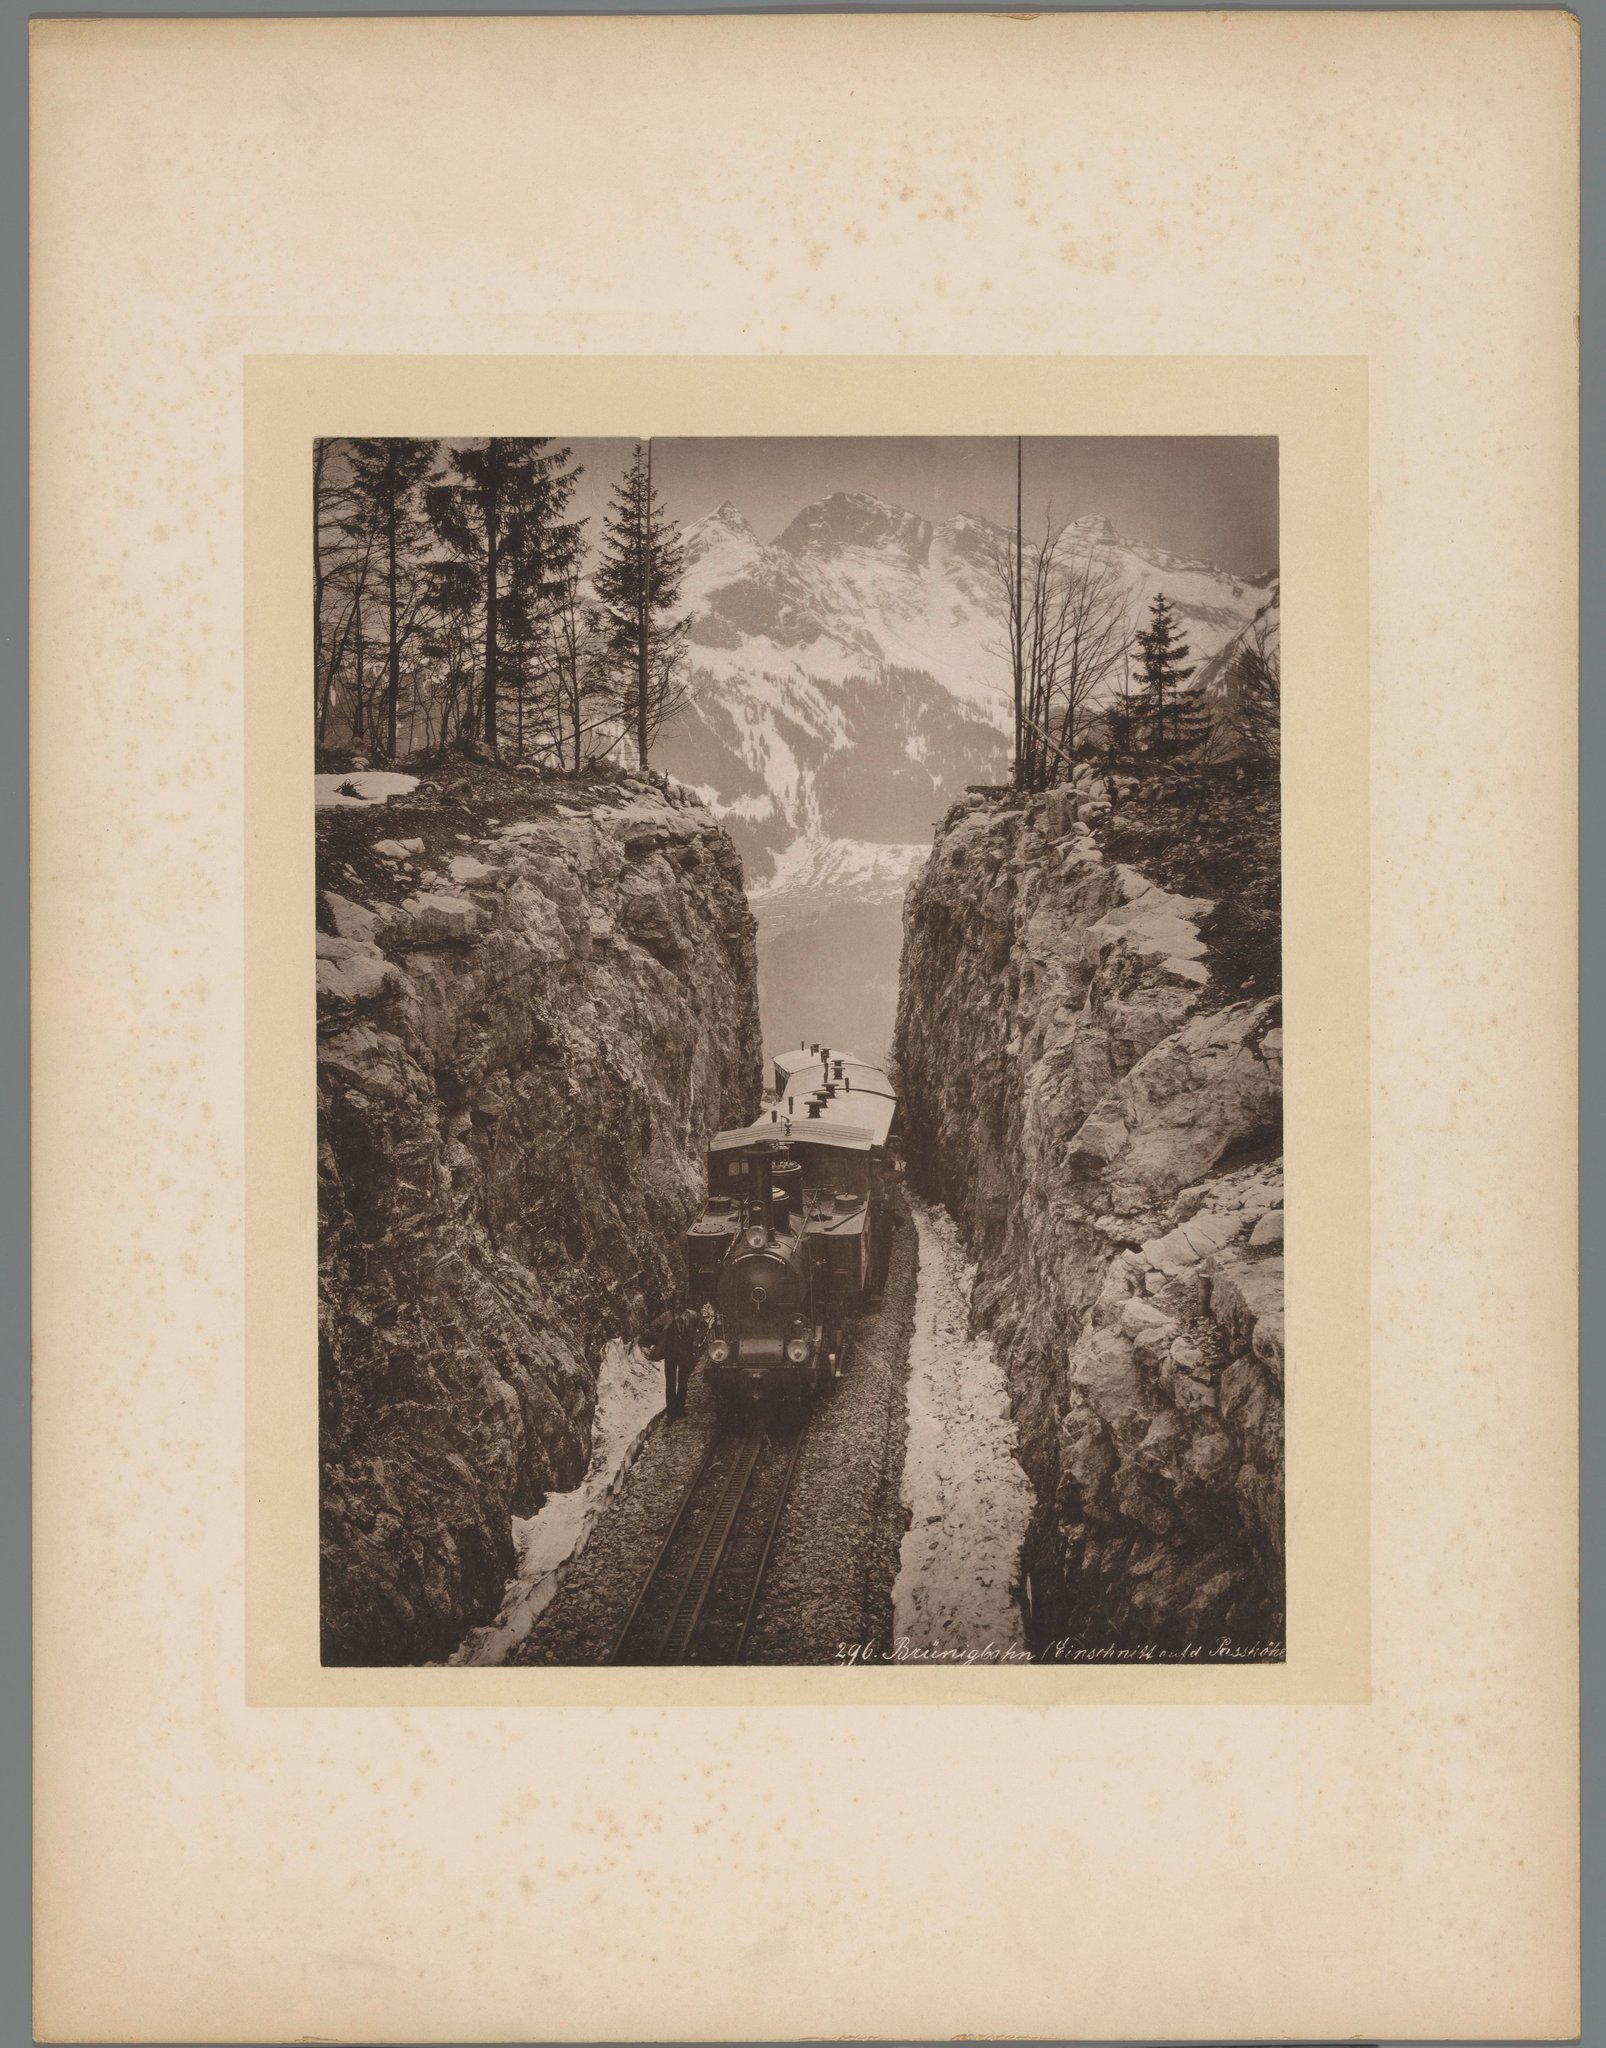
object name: photomechanical print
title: Stoomlocomotief op de Brünigbahn tussen Luzern en Interlaken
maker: Anonymous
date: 1888-1930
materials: cardboard, paper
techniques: photograph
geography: switzerland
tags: railway, train, steam locomotive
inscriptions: number: ‘296.’